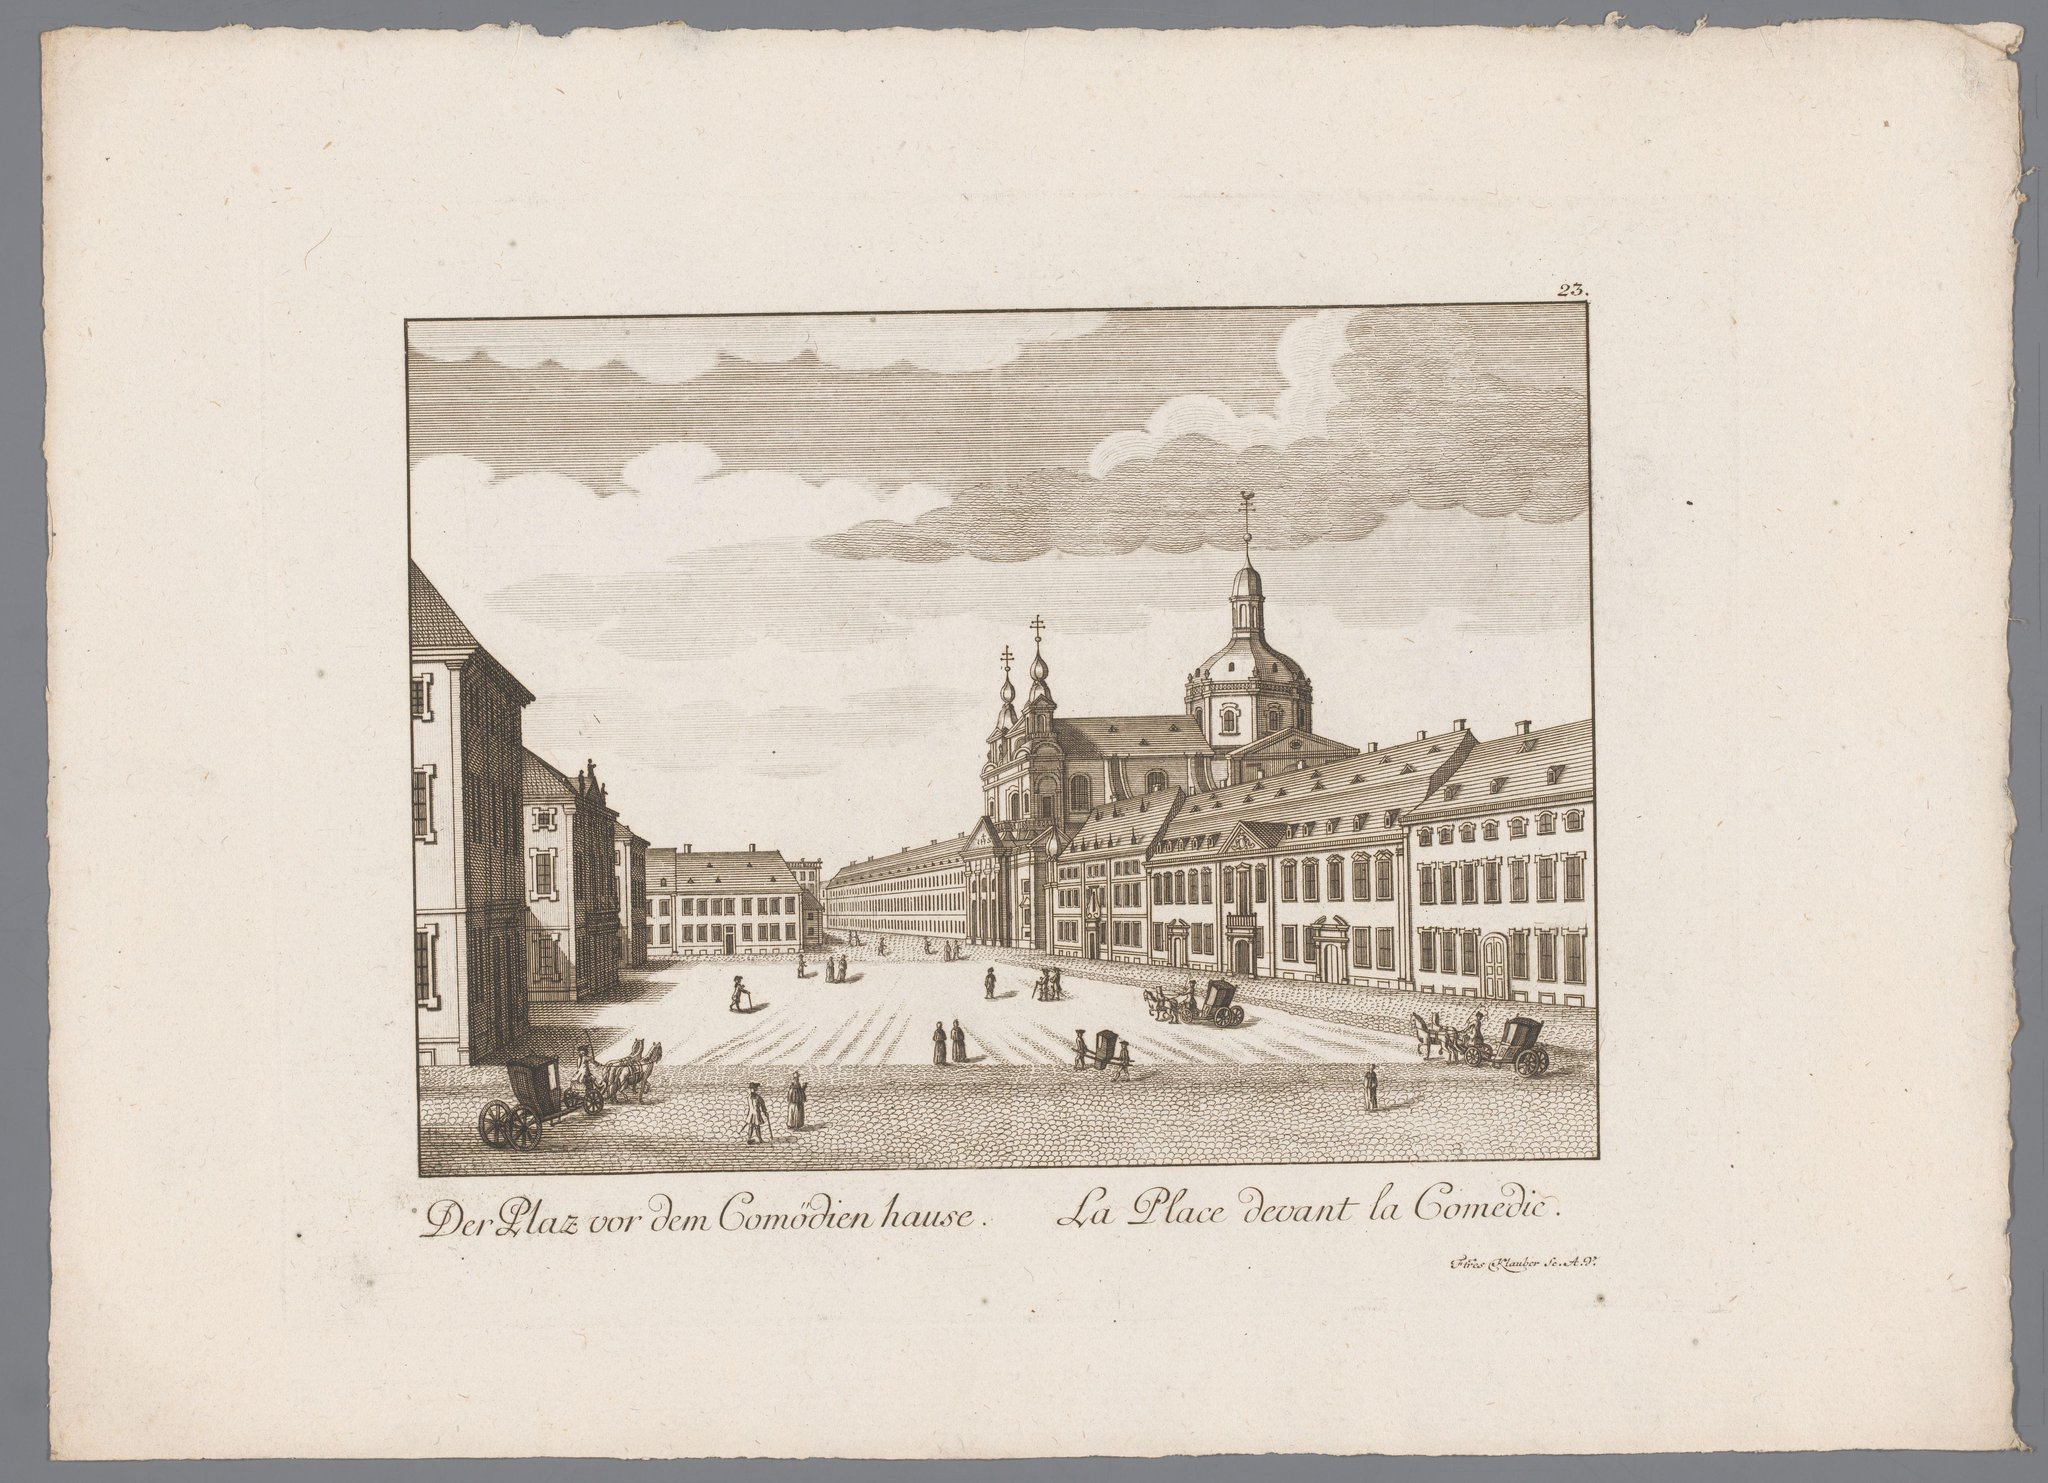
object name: print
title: Vues de Mannheim représentées sur vingt six planches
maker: christian friedrich schwan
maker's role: bookseller, publisher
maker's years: 1733-1815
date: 1782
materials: paper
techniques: engraving, etching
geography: augsburg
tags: square, place, circus, etc., theatre (building)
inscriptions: collector's mark: Lugt 2228